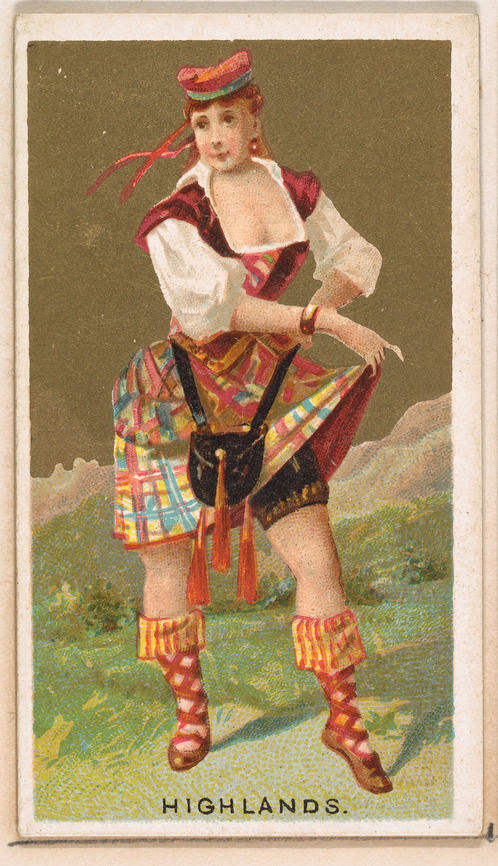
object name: print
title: Highlands, from the Dancing Girls of the World series (N185) issued by Wm. S. Kimball & Co.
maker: william s. kimball & company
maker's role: publisher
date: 1889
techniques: color lithograph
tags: women,dancing,dancers